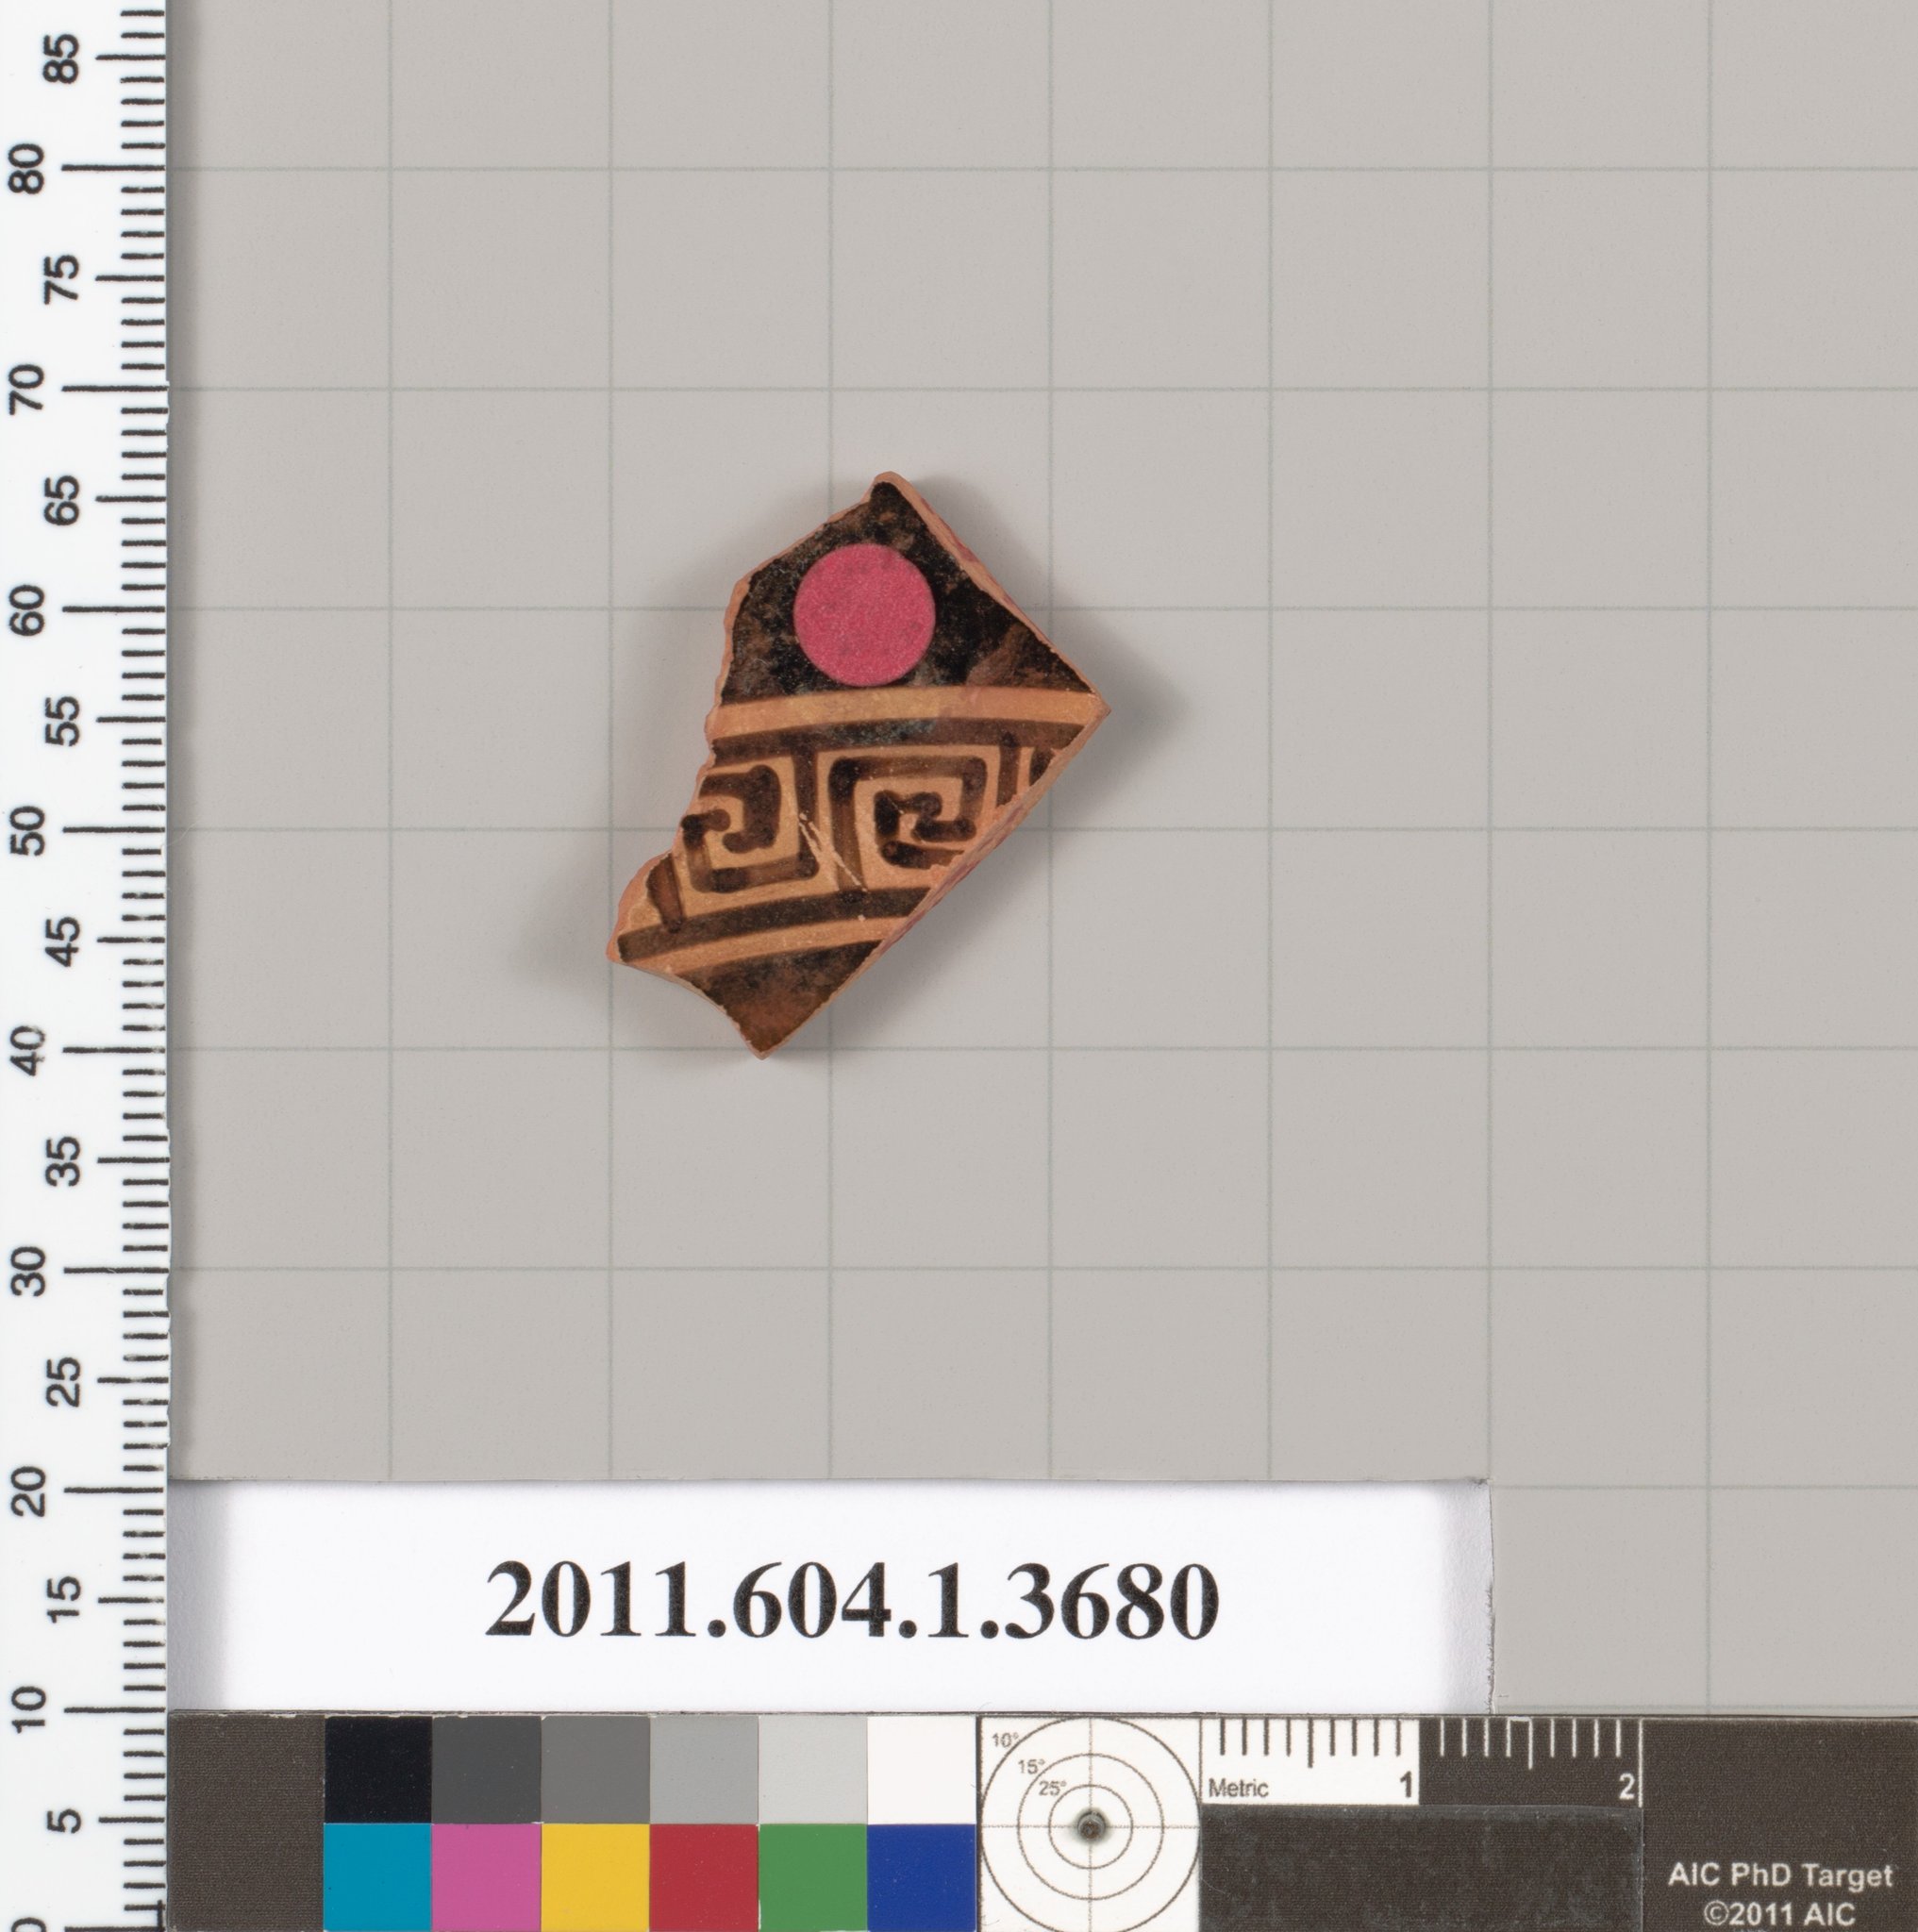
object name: kylix fragment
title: Terracotta fragment of a kylix (drinking cup)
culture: greek, attic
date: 475-451 BCE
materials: terracotta